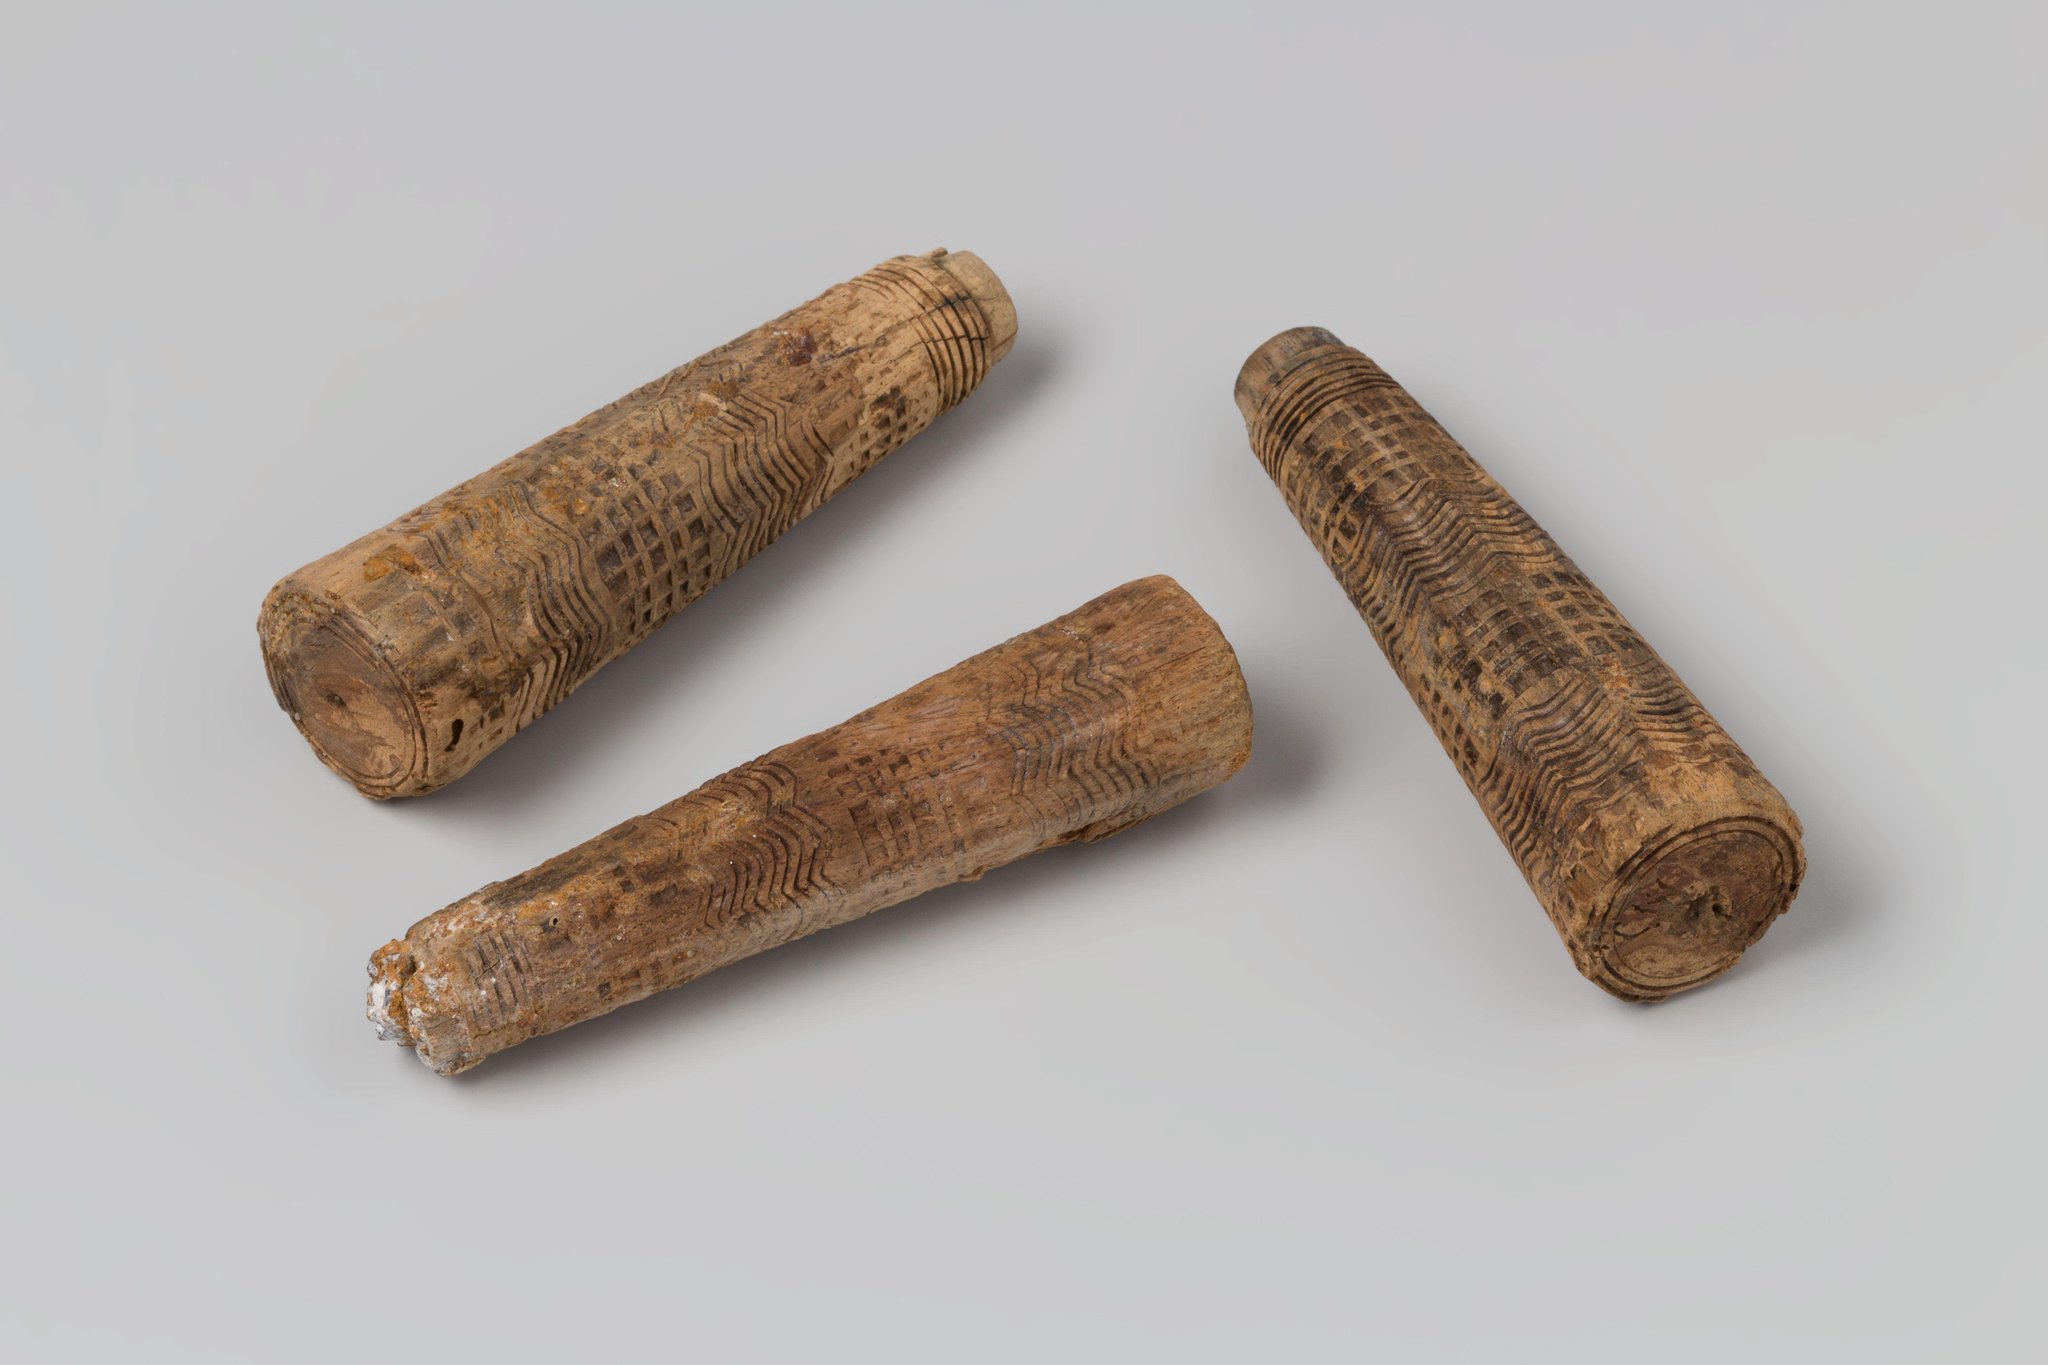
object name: knife handle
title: Messenheften uit het wrak van de Oost-Indiëvaarder Hollandia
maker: Anonymous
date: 1700-1743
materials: wood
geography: netherlands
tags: verenigde oostindische compagnie, hollandia (schip), annet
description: Knife, handle, cylindrical: tapering; id. NG 1979-403H, ferrules, id. NG 1980-27H426.